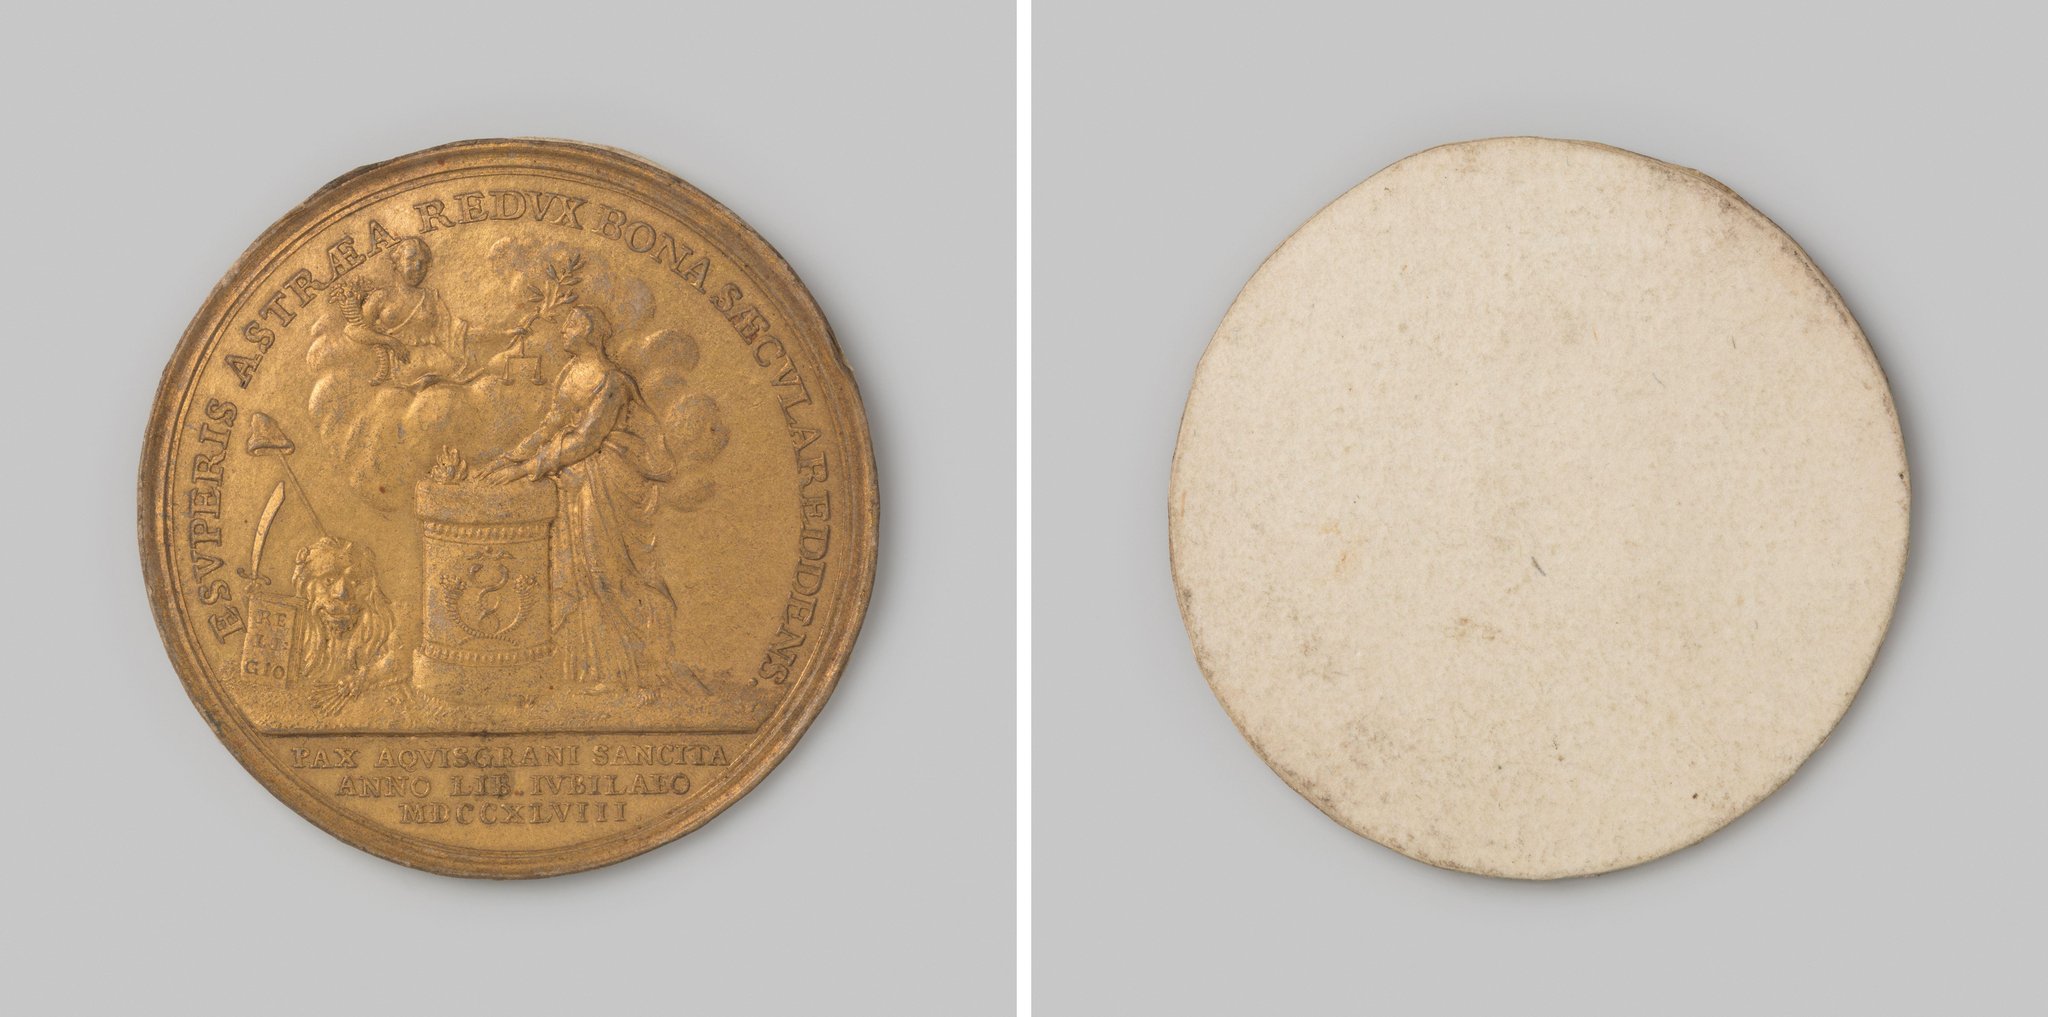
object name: history medal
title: Vrede van Aken 1748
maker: martinus holtzhey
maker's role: medailleur, muntmaker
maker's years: 1697-1764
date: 1748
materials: cardboard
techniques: pressing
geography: amsterdam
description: Vergulde afdruk in karton van het keerzijdestempel: Astraea op een wolk neerdalend ter aarde waar de Godsvrucht een altaar voor haar brandt, waarnaast de Nederlandse leeuw ligt met zwaard, bijbel en piek met vrijheidshoed, met omschrift en afsnedetekst.